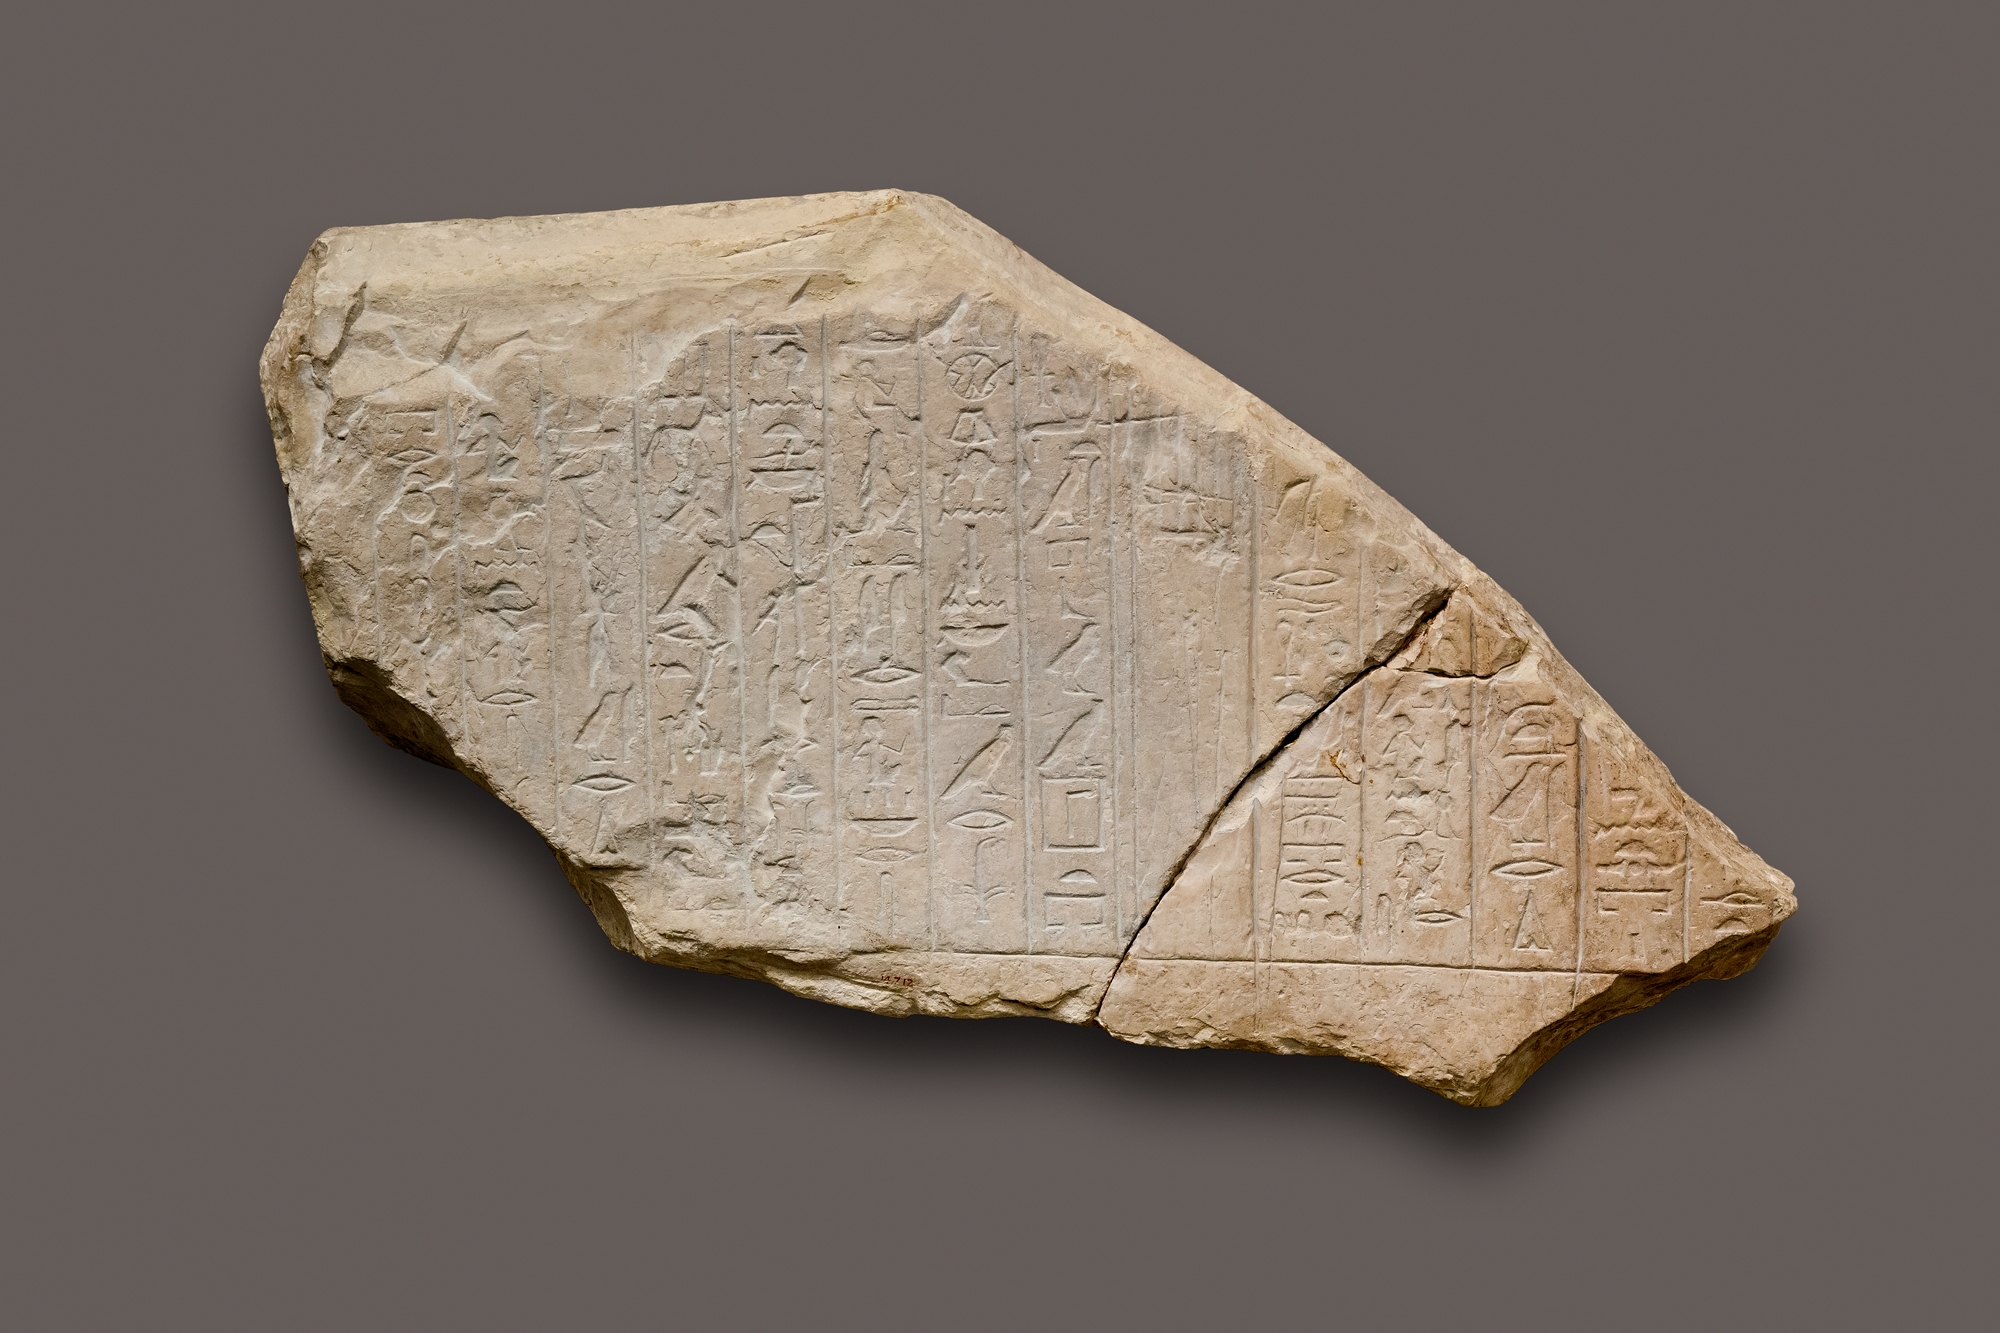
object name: relief, decree of king neferkauhor horus netjerybau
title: Fragmentary decree of King Neferkauhor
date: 2103-2101 BCE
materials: limestone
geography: egypt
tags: hieroglyphs